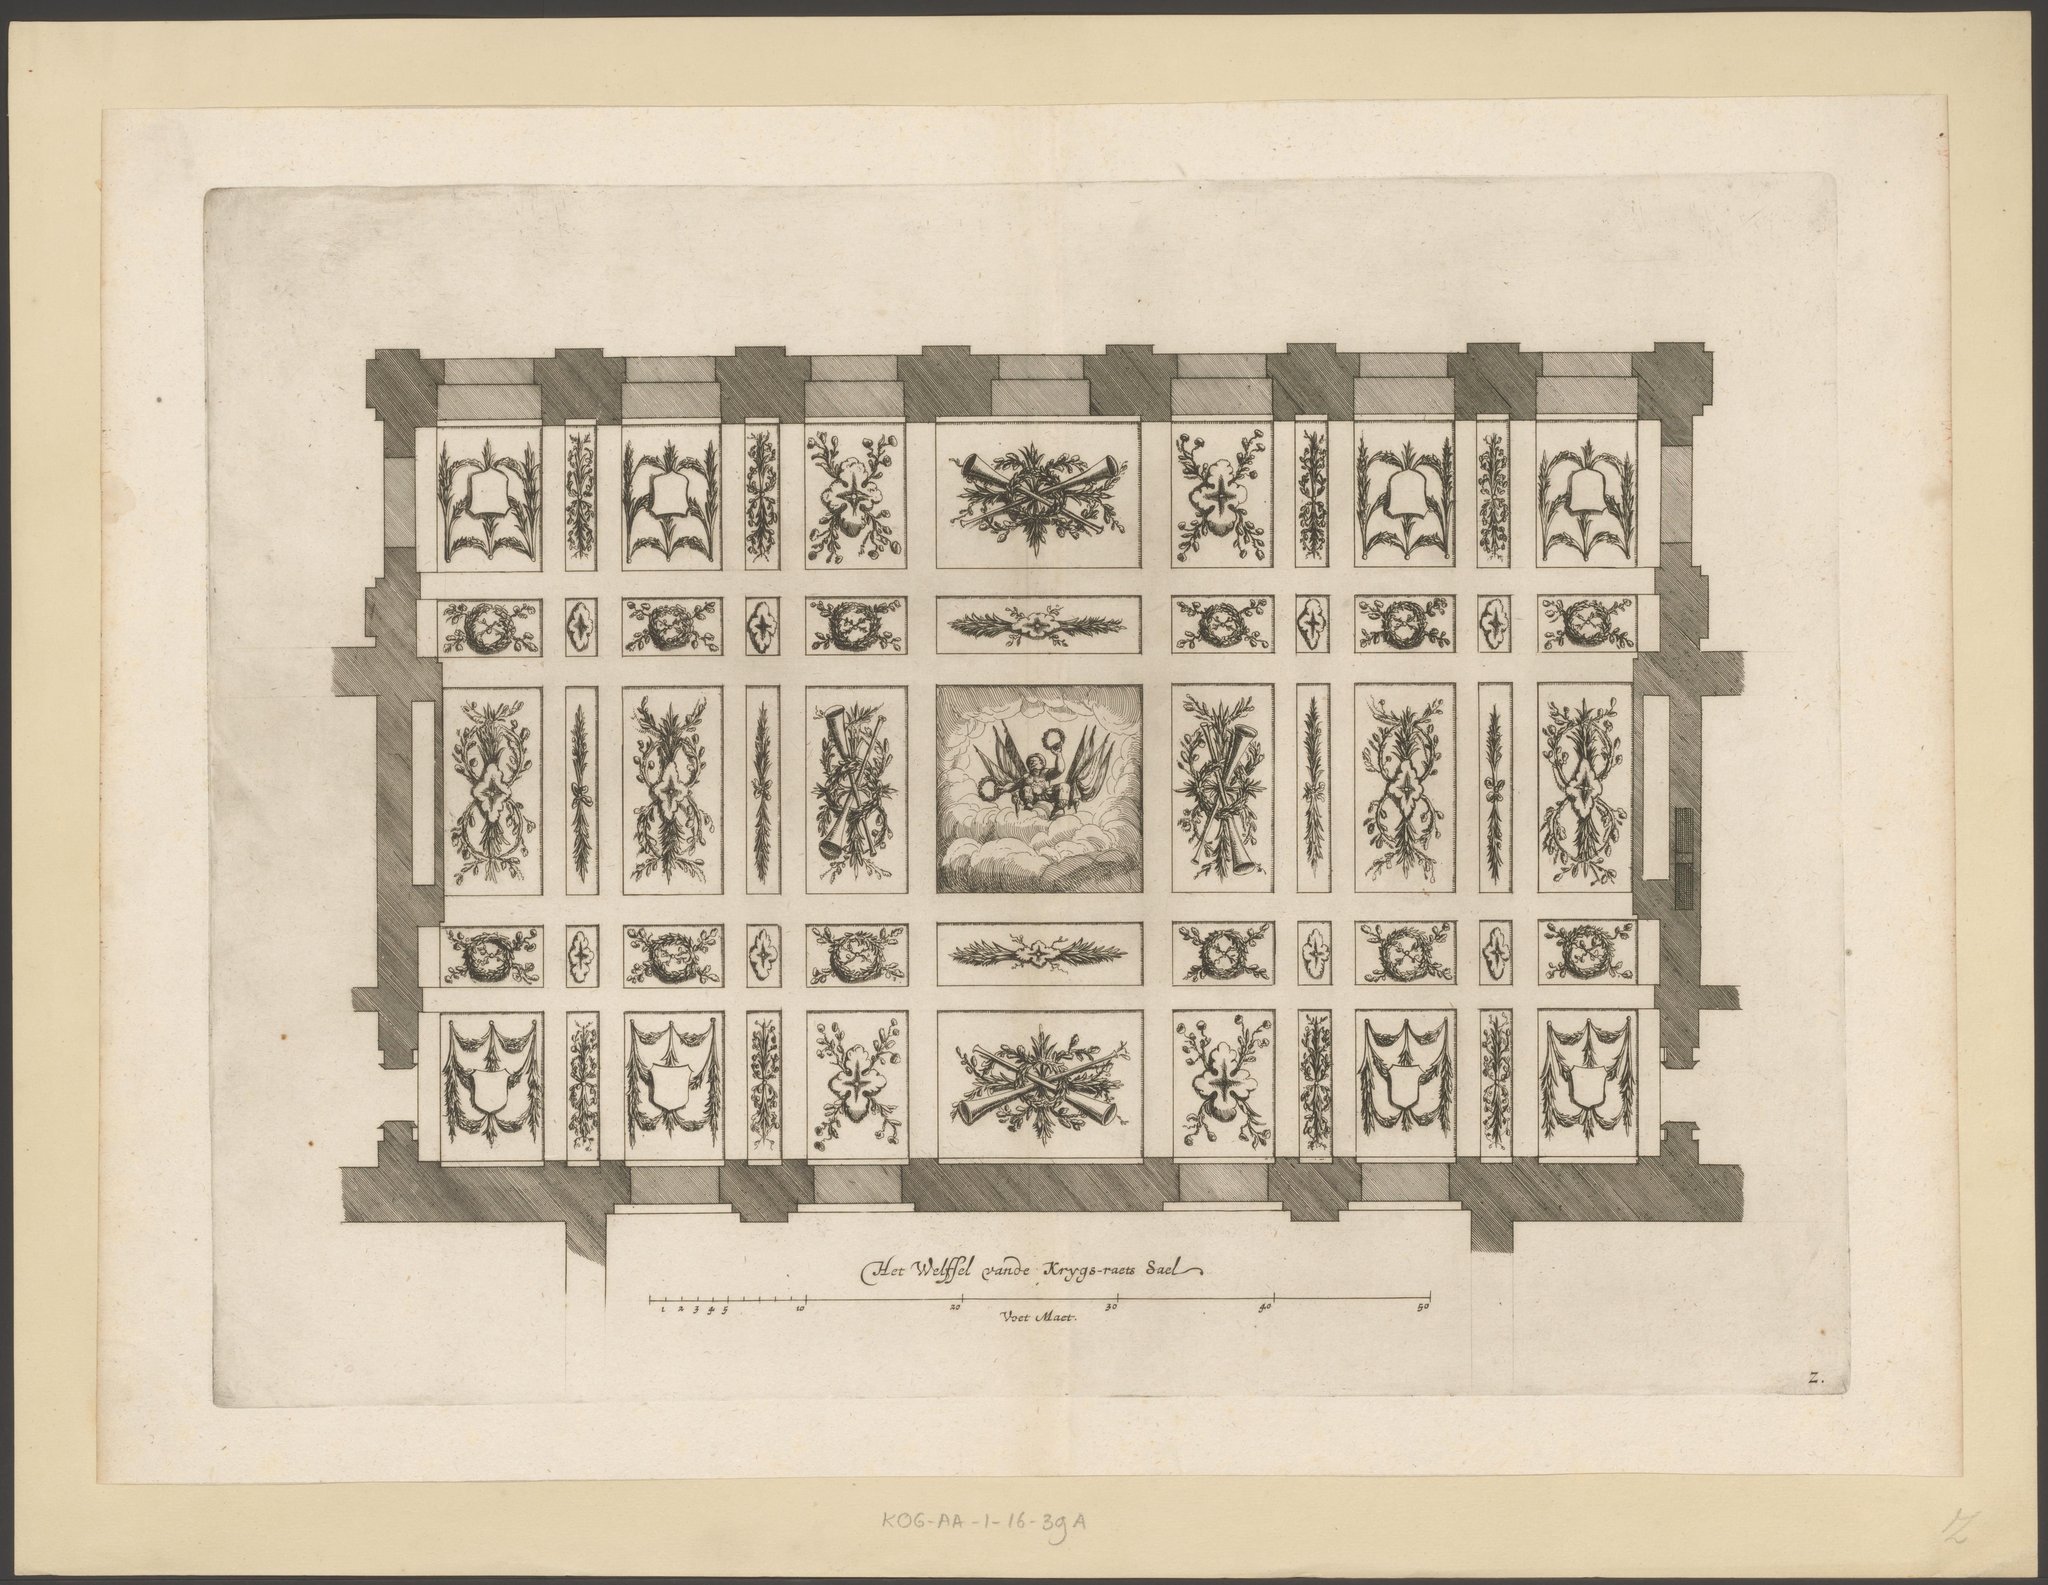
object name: print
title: Het Welfsel vande Krygs-raets Sael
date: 1661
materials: paper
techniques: engraving, etching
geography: amsterdam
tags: interior ~ architectural design or model, townhall, council of war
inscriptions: collector's mark: ‘16,39A’ Lugt 1641b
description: Onderwerpsrubriek binnen de Atlas Amsterdam: Stadhuis op de Dam. Rechtsonder: Z.